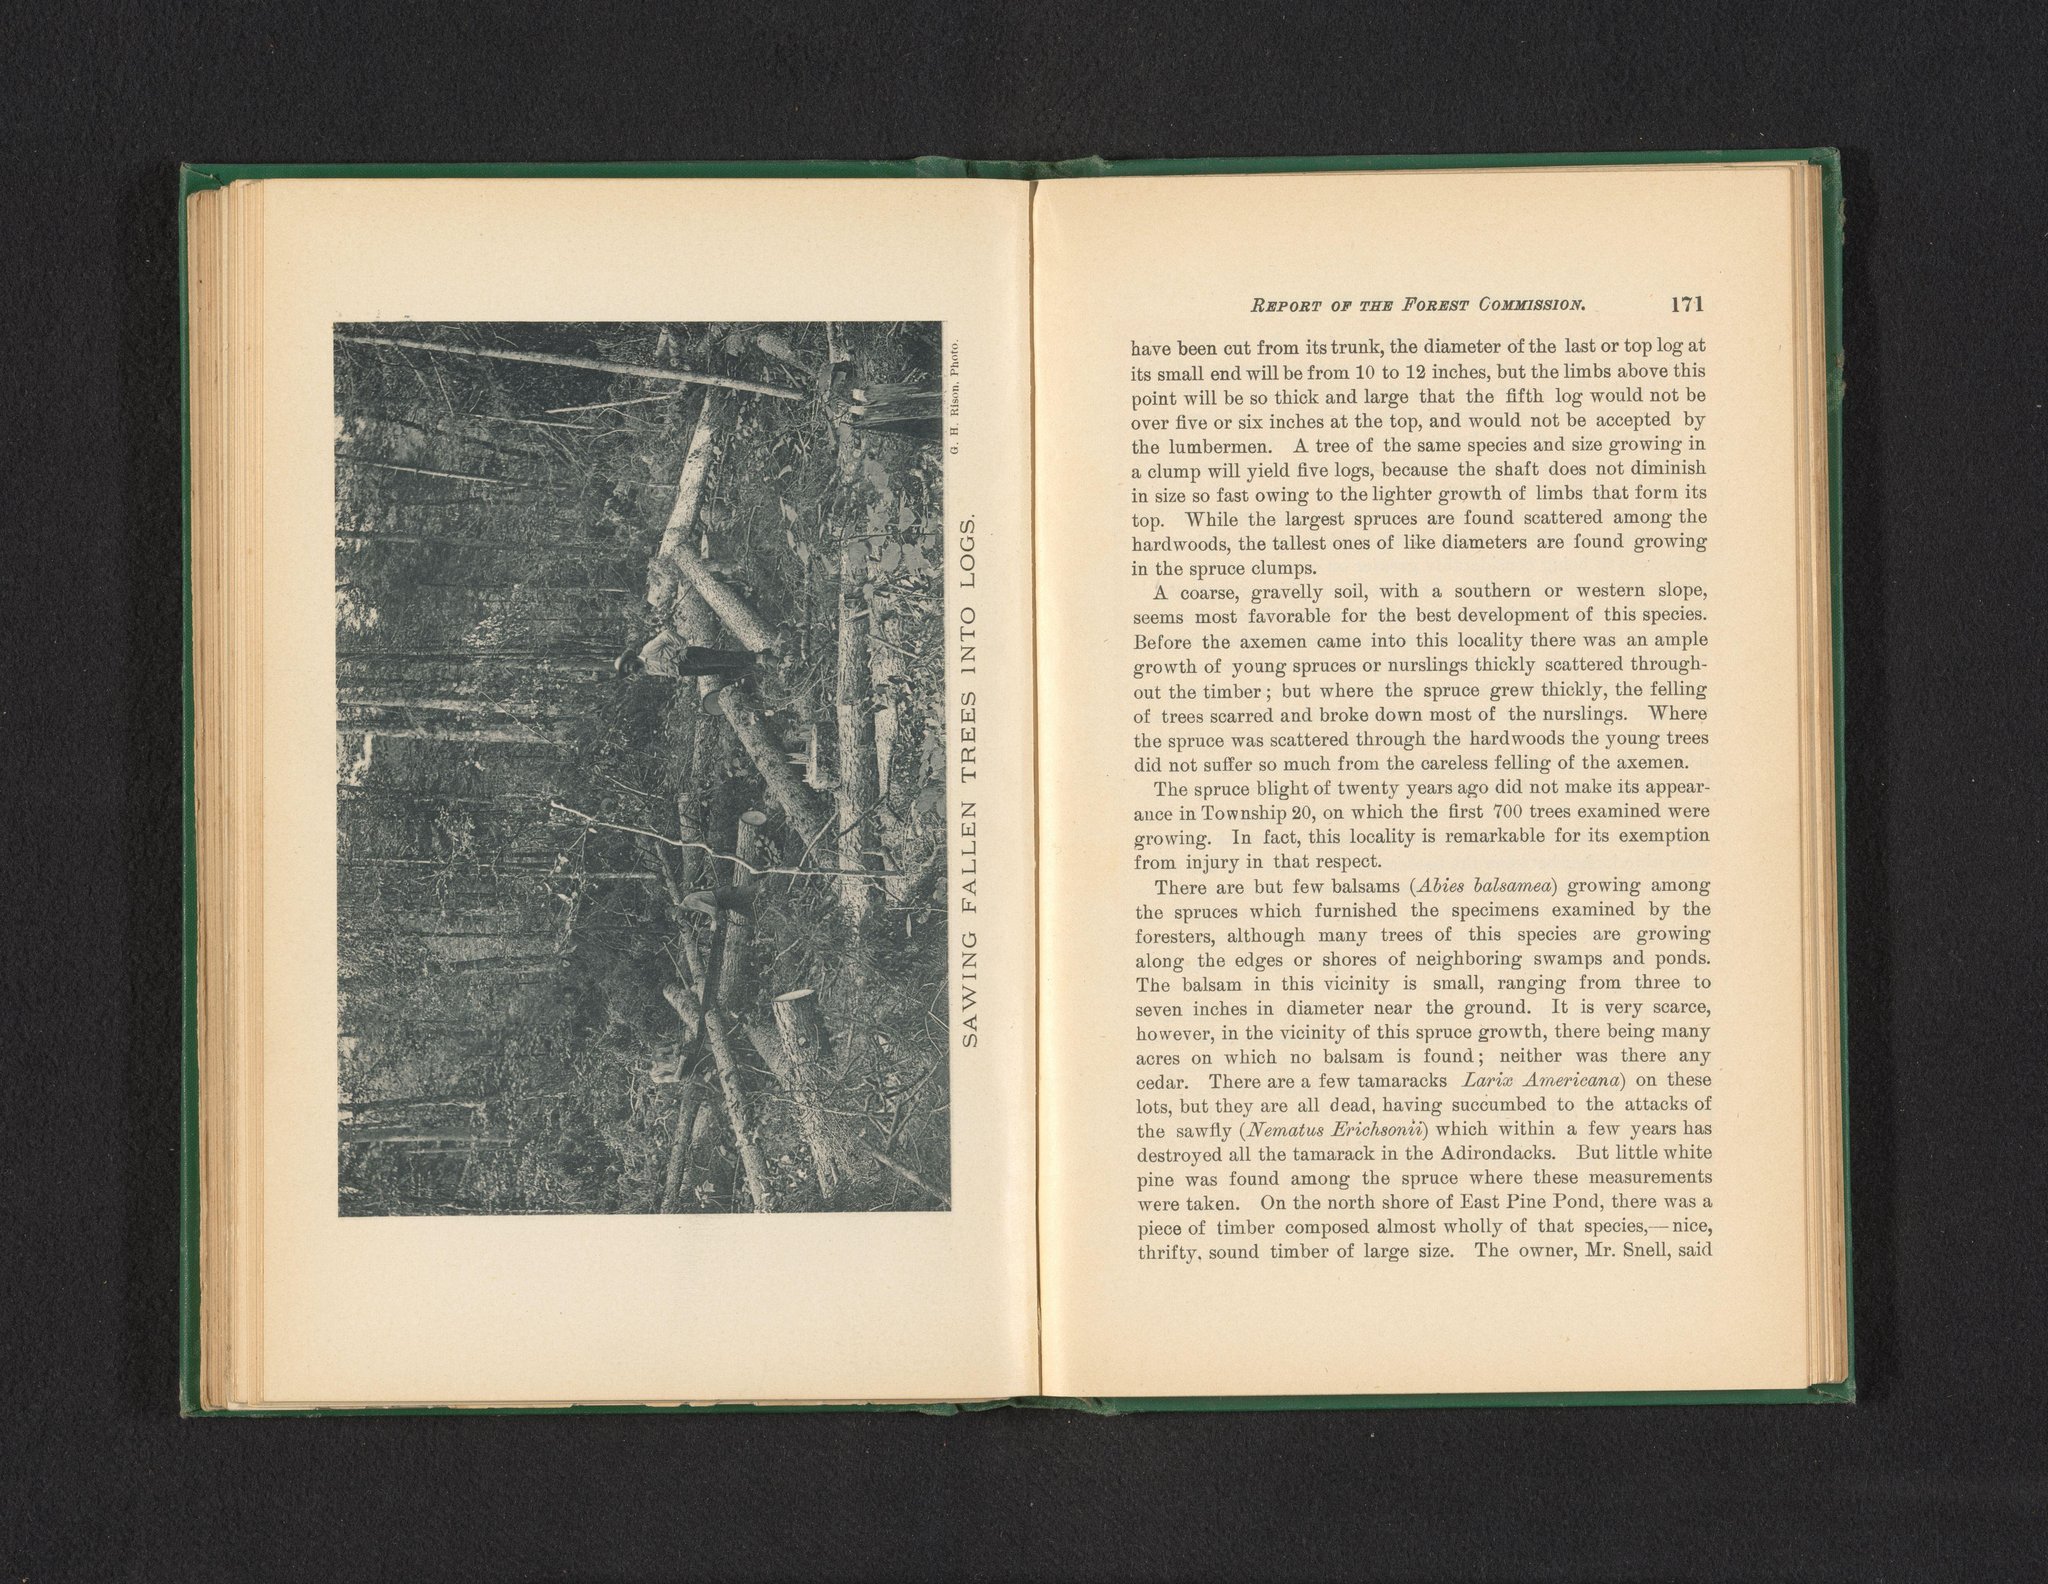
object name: page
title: Sawing fallen trees into logs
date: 1894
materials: paper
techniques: photograph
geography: new york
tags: forestry, beam, log of wood